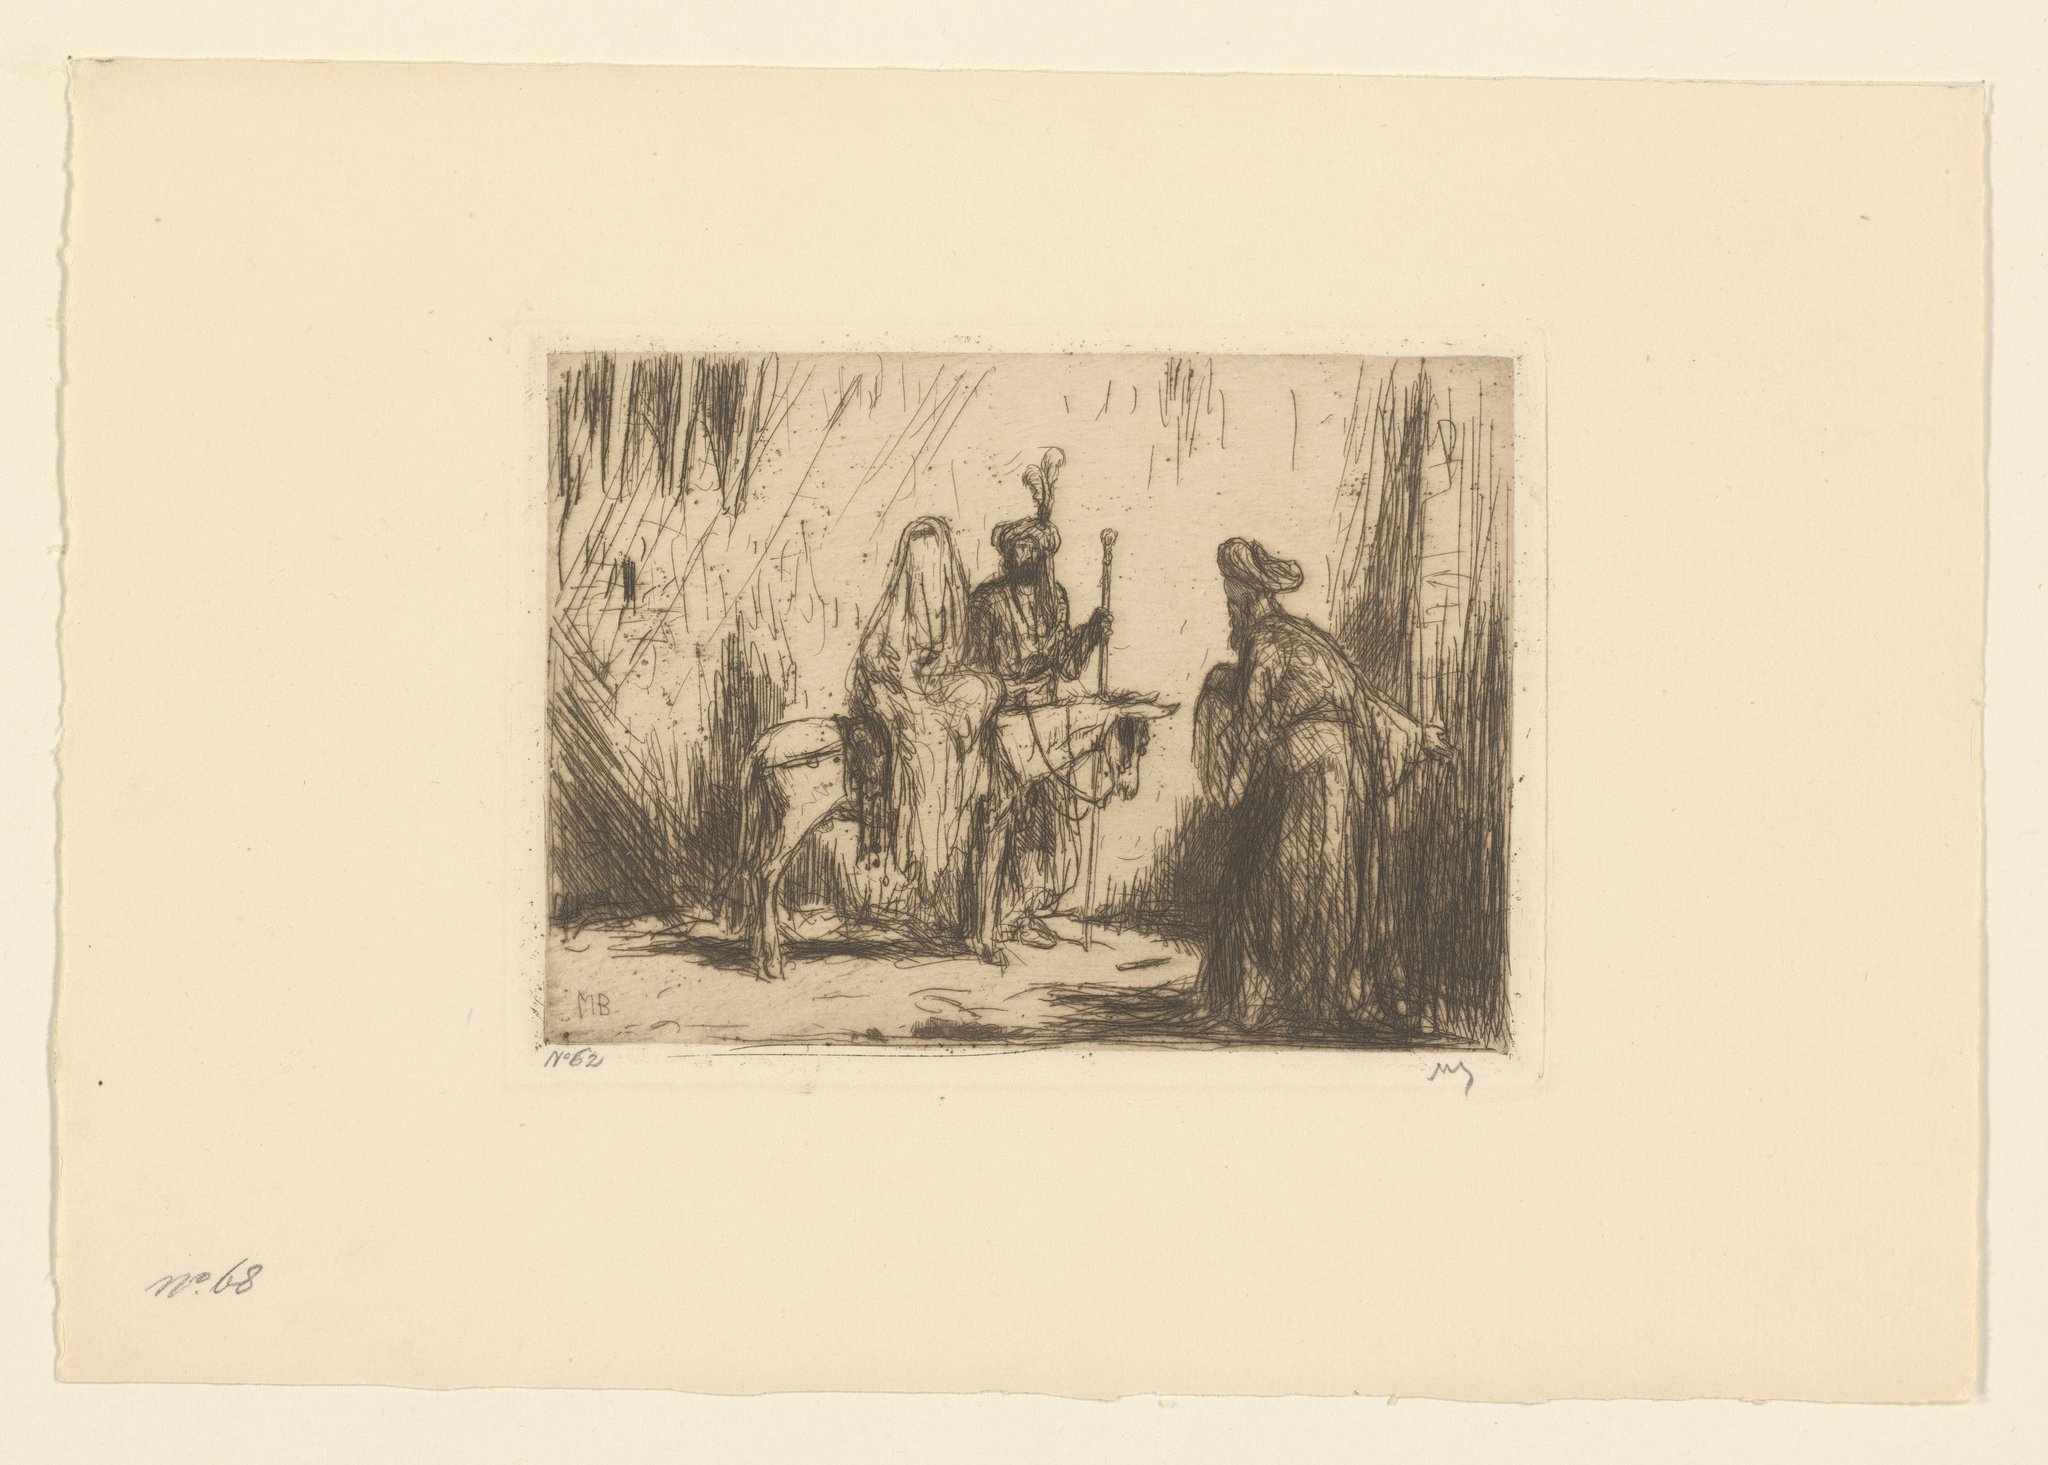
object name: print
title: Man heet bezoek welkom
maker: marius bauer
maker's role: draughtsman, print maker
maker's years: 1867-1932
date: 1901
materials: paper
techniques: etching, intaglio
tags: ass, donkey, being welcomed ~ travelling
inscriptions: collector's mark: Lugt 2228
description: Een gesluierde vrouw op een ezel, naast haar een staande man. Rechts van hen een staande man die hen wenkt naderbij te komen.